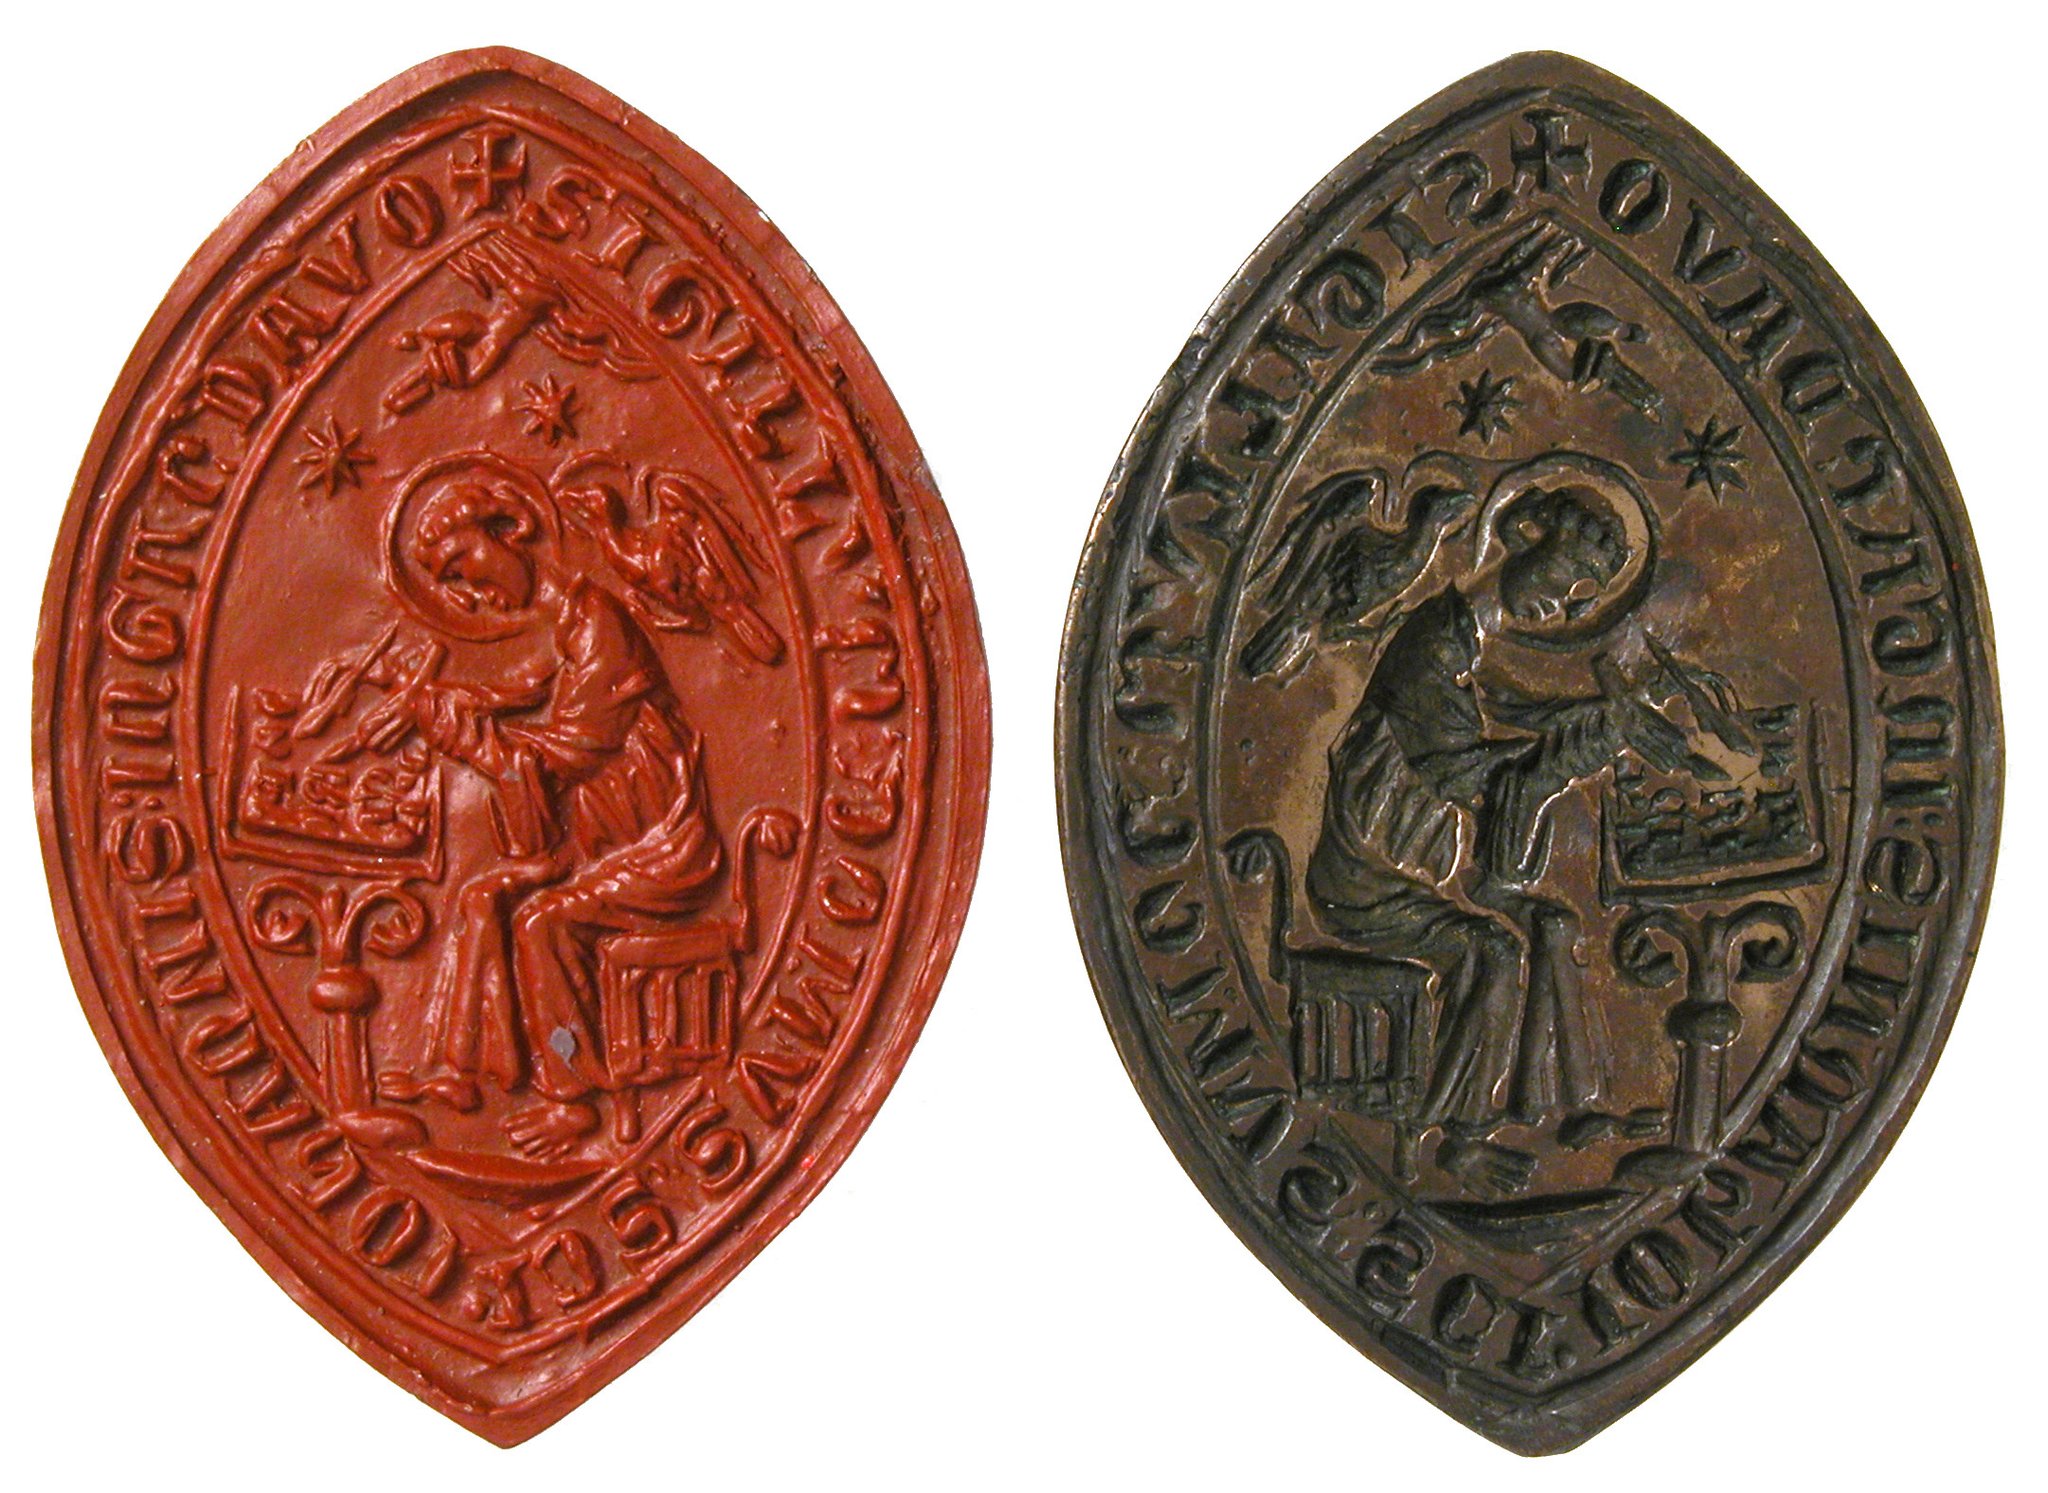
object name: seal matrix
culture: south netherlandish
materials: bronze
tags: birds,saint john the evangelist